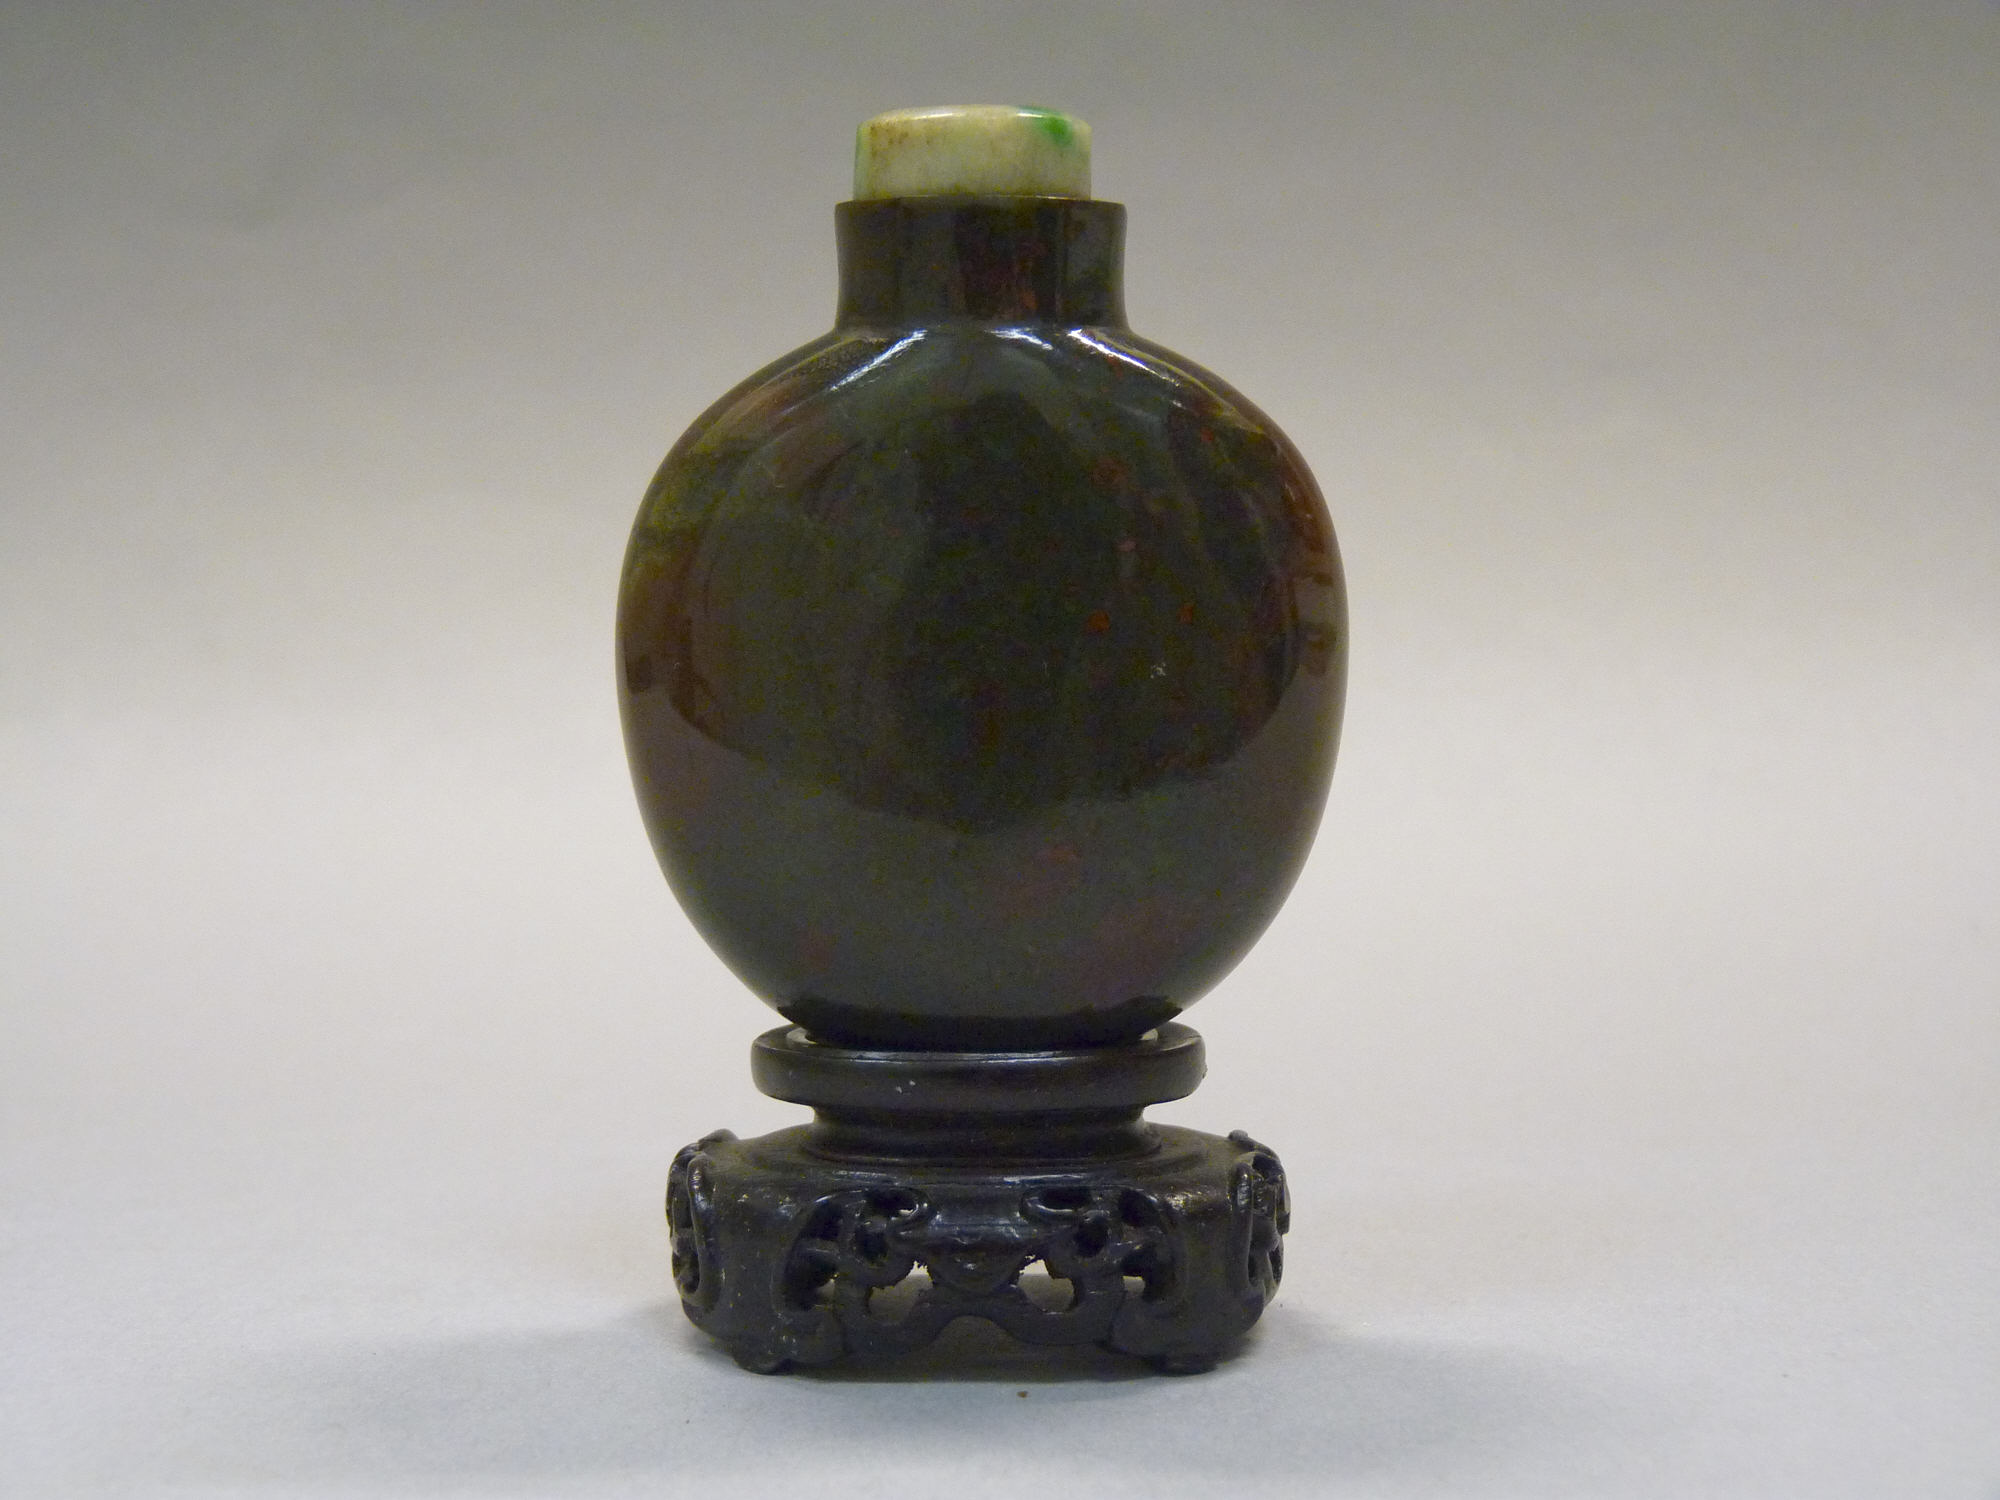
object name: snuff bottle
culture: chinese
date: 1736-1795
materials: stone, jade